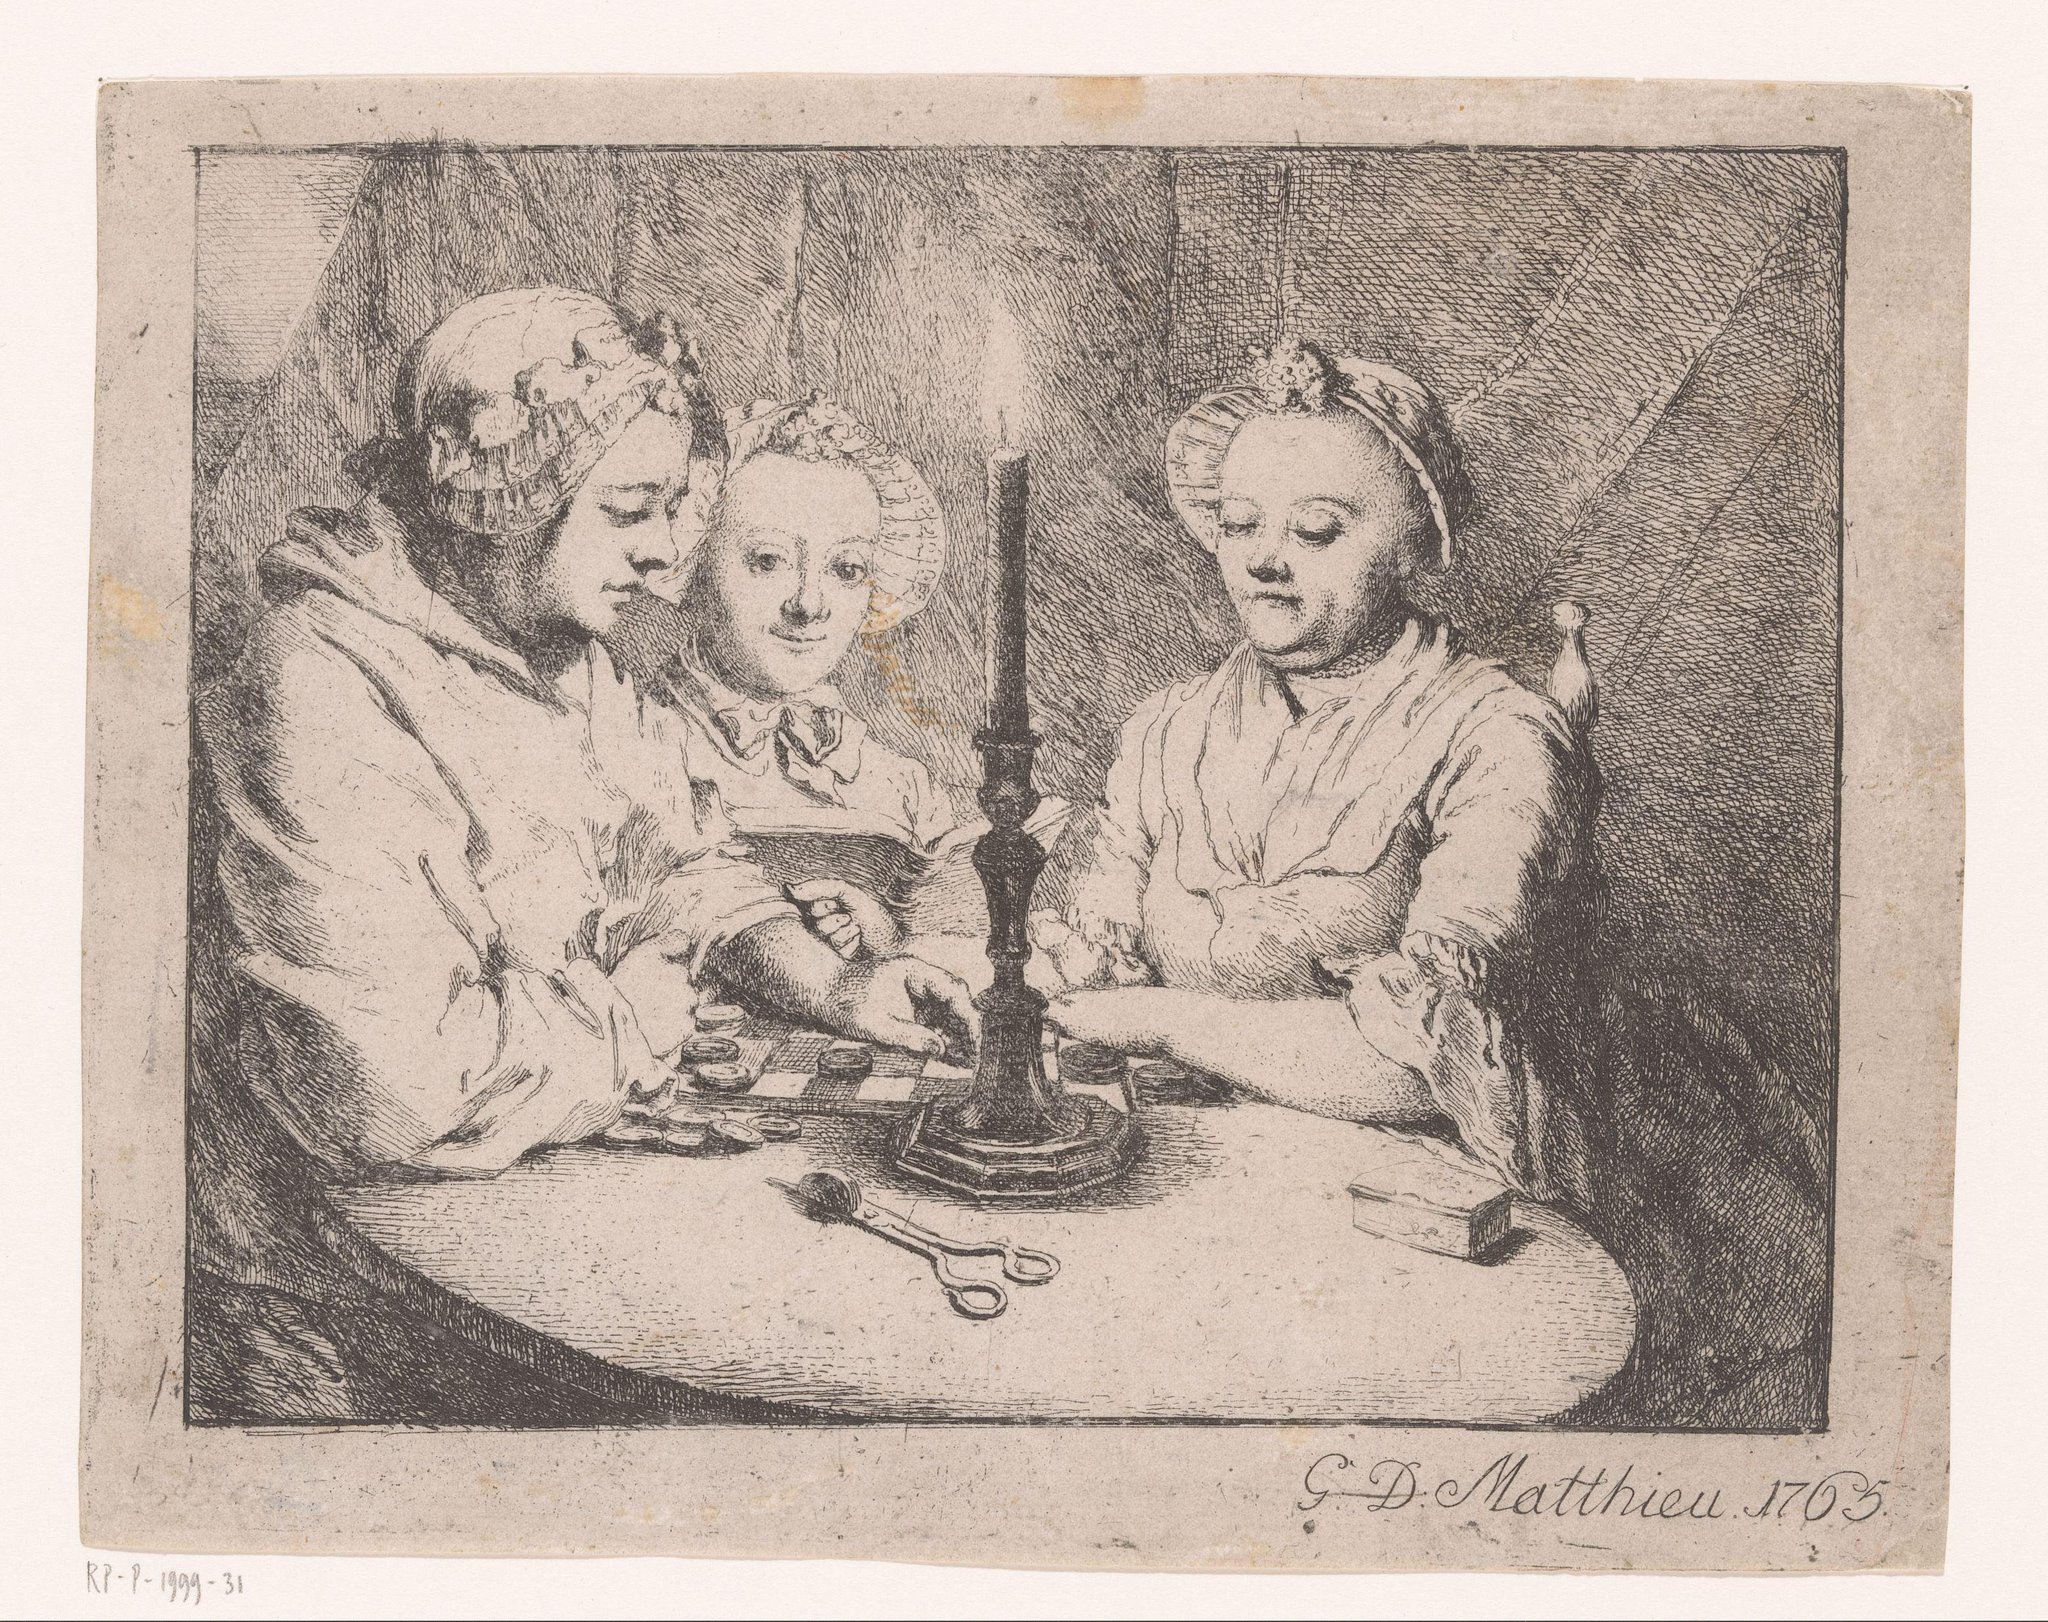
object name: print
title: Damspelende dames bij kaarslicht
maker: georg david matthieu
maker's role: print maker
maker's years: 1737-1778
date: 1765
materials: paper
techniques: etching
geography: germany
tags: adult woman, book, candle, board-games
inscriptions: collector's mark, collector's mark: Lugt 2760, collector's mark: Lugt 2228, collector's mark: Lugt 1606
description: Drie dames met een muts op hun hoofd zitten aan een ronde tafel waarop een kaars brand. Eén van hen heeft een boek in de handen en kijkt toe hoe de andere twee zitten te dammen.